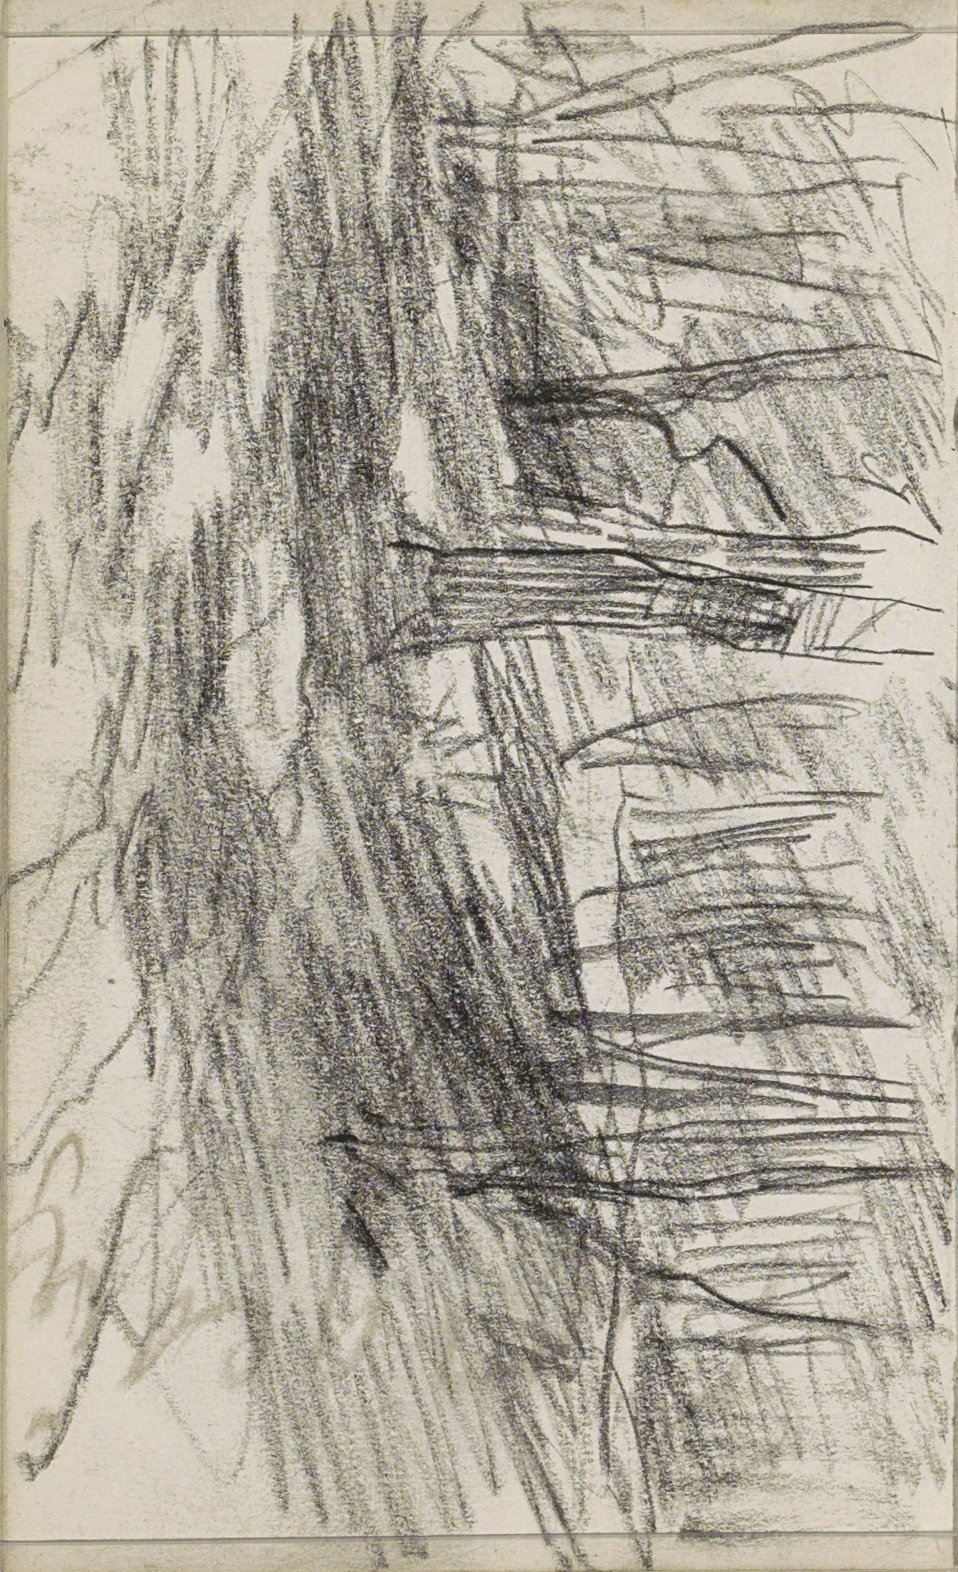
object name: sketchbook leaf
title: Bosgrond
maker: anton mauve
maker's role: draughtsman, painter, print maker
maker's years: 1838-1888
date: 1848-1888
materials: chalk, paper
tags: forest, wood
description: Blad 53 verso uit een schetsboek met 53 bladen.